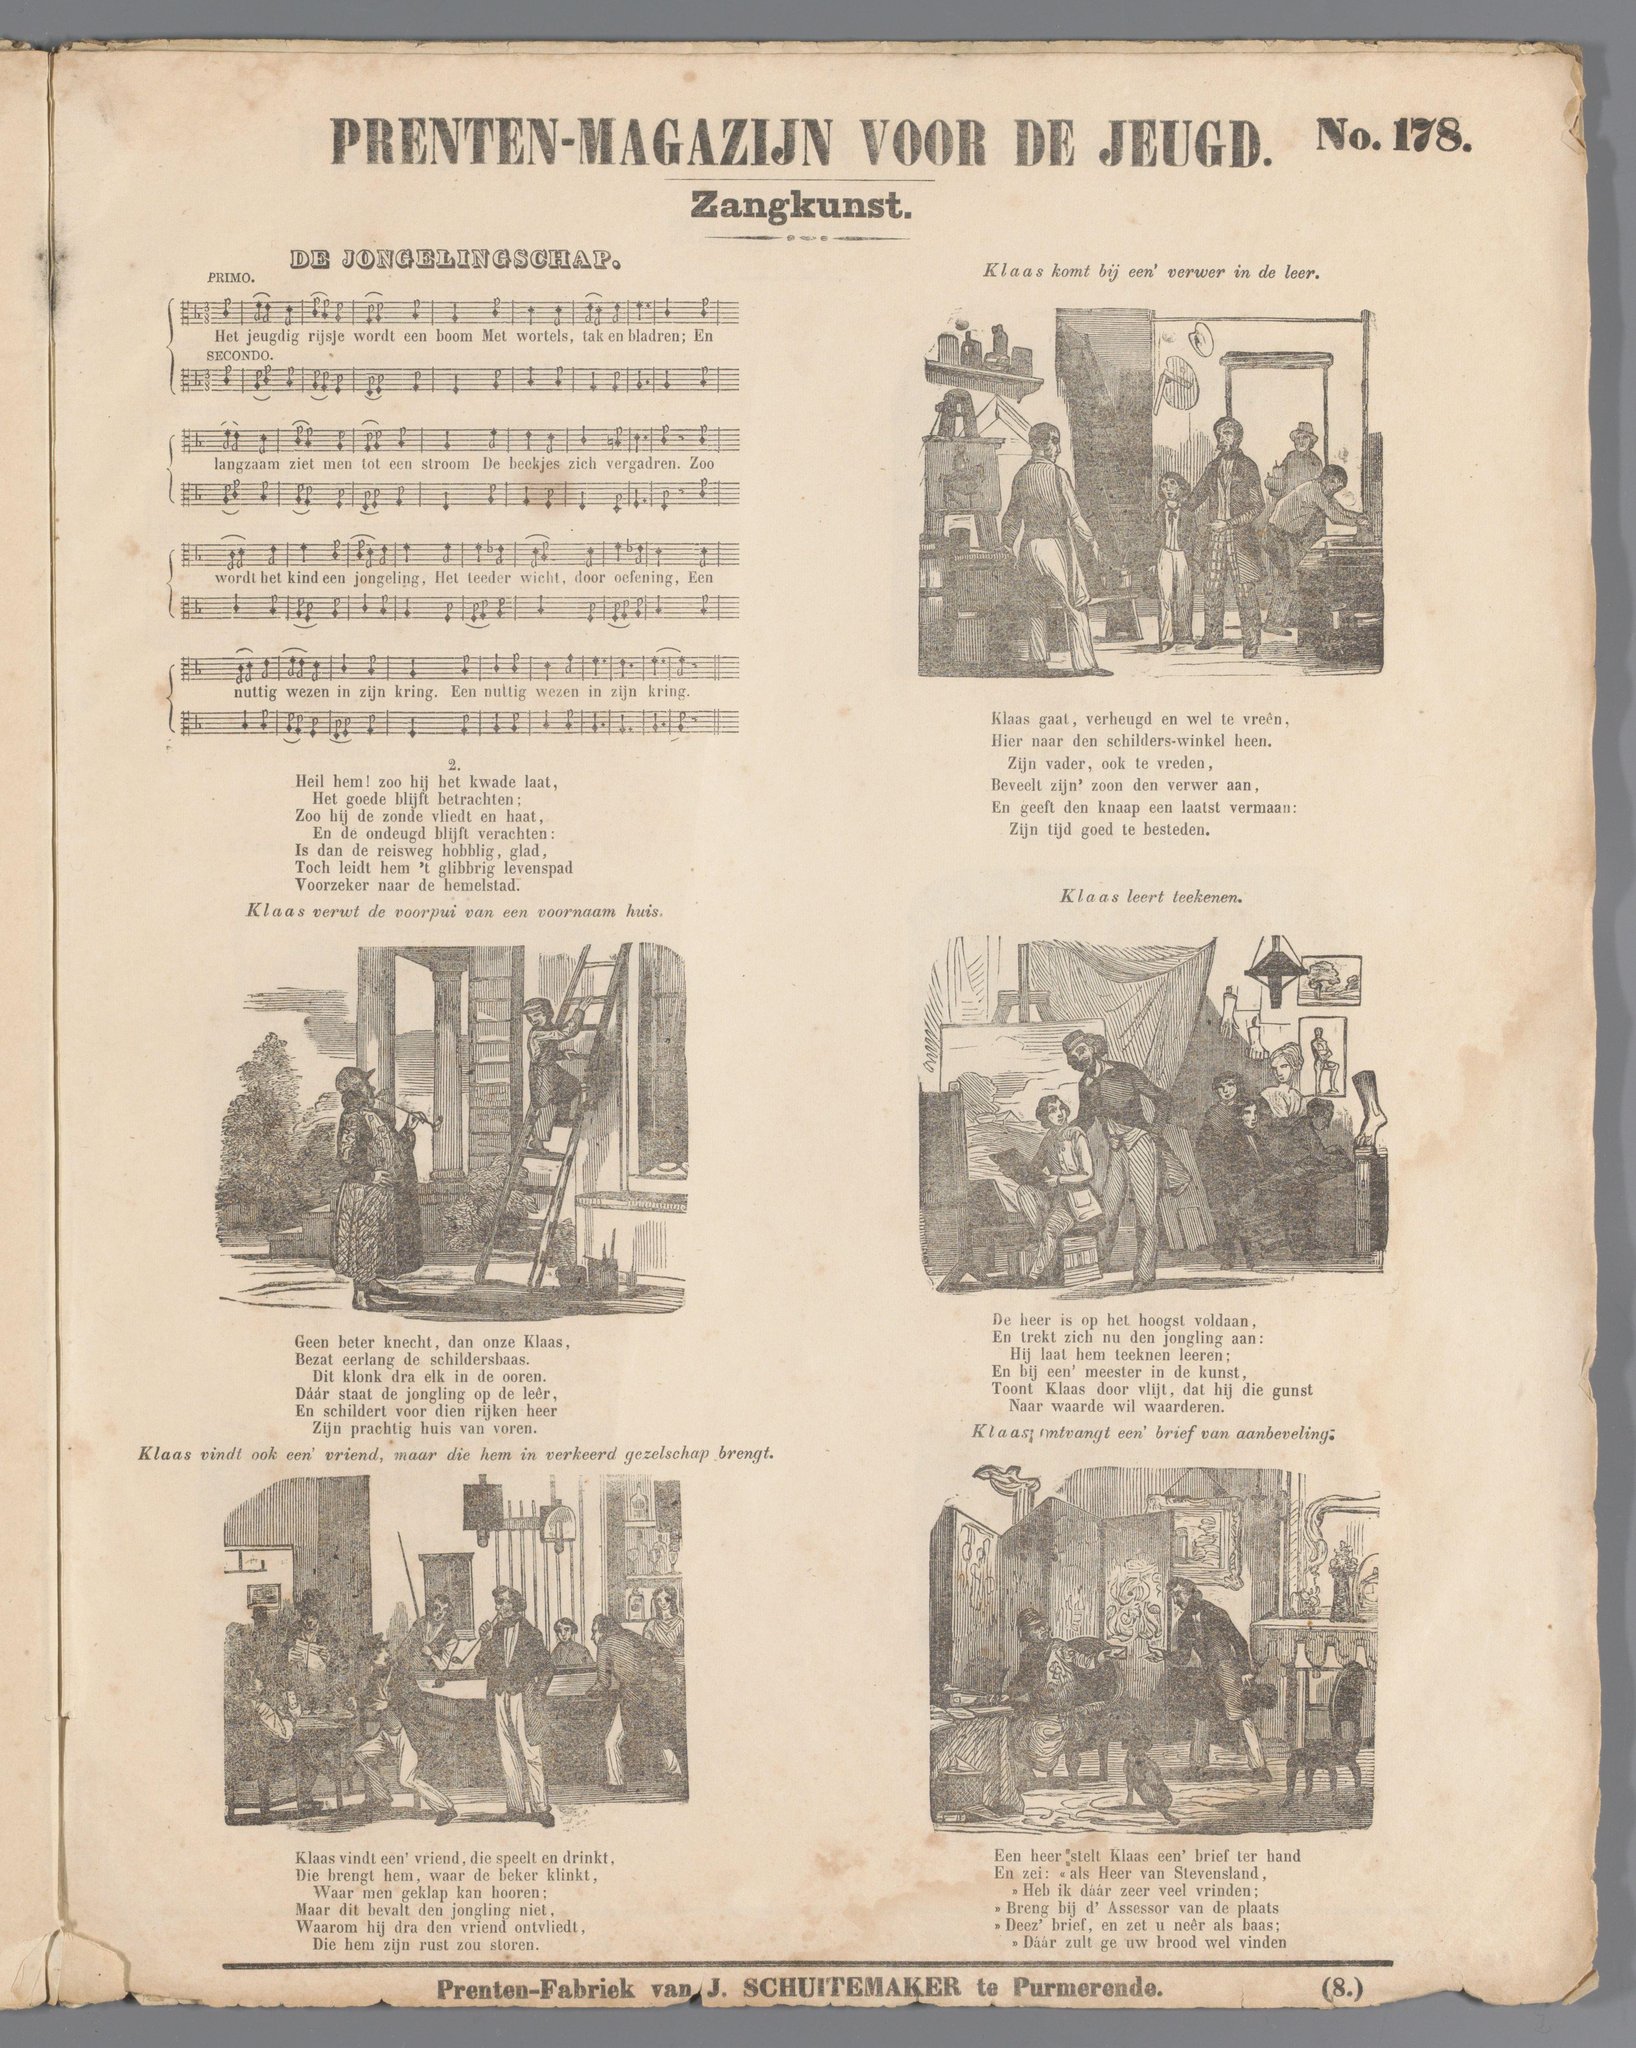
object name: print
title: Groot en goed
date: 1853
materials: paper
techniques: letterpress printing, engraving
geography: purmerend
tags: printed edition of musical score, painter training pupils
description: Blad met muziekstuk 'De jongelingschap' en 5 voorstellingen: Klaas komt bij een schilder in de leer, Klaas schildert de voorpui van een voornaam huis, Klaas leert tekenen, Klaas vindt ook een vriend, maar die hem in verkeerd gezelschap brengt en Klaas ontvangt een brief van aanbeveling. Onder de voorstellingen diverse coupletten van het muziekstuk. Genummerd rechtsboven: No. 178, linksonder: (8.).